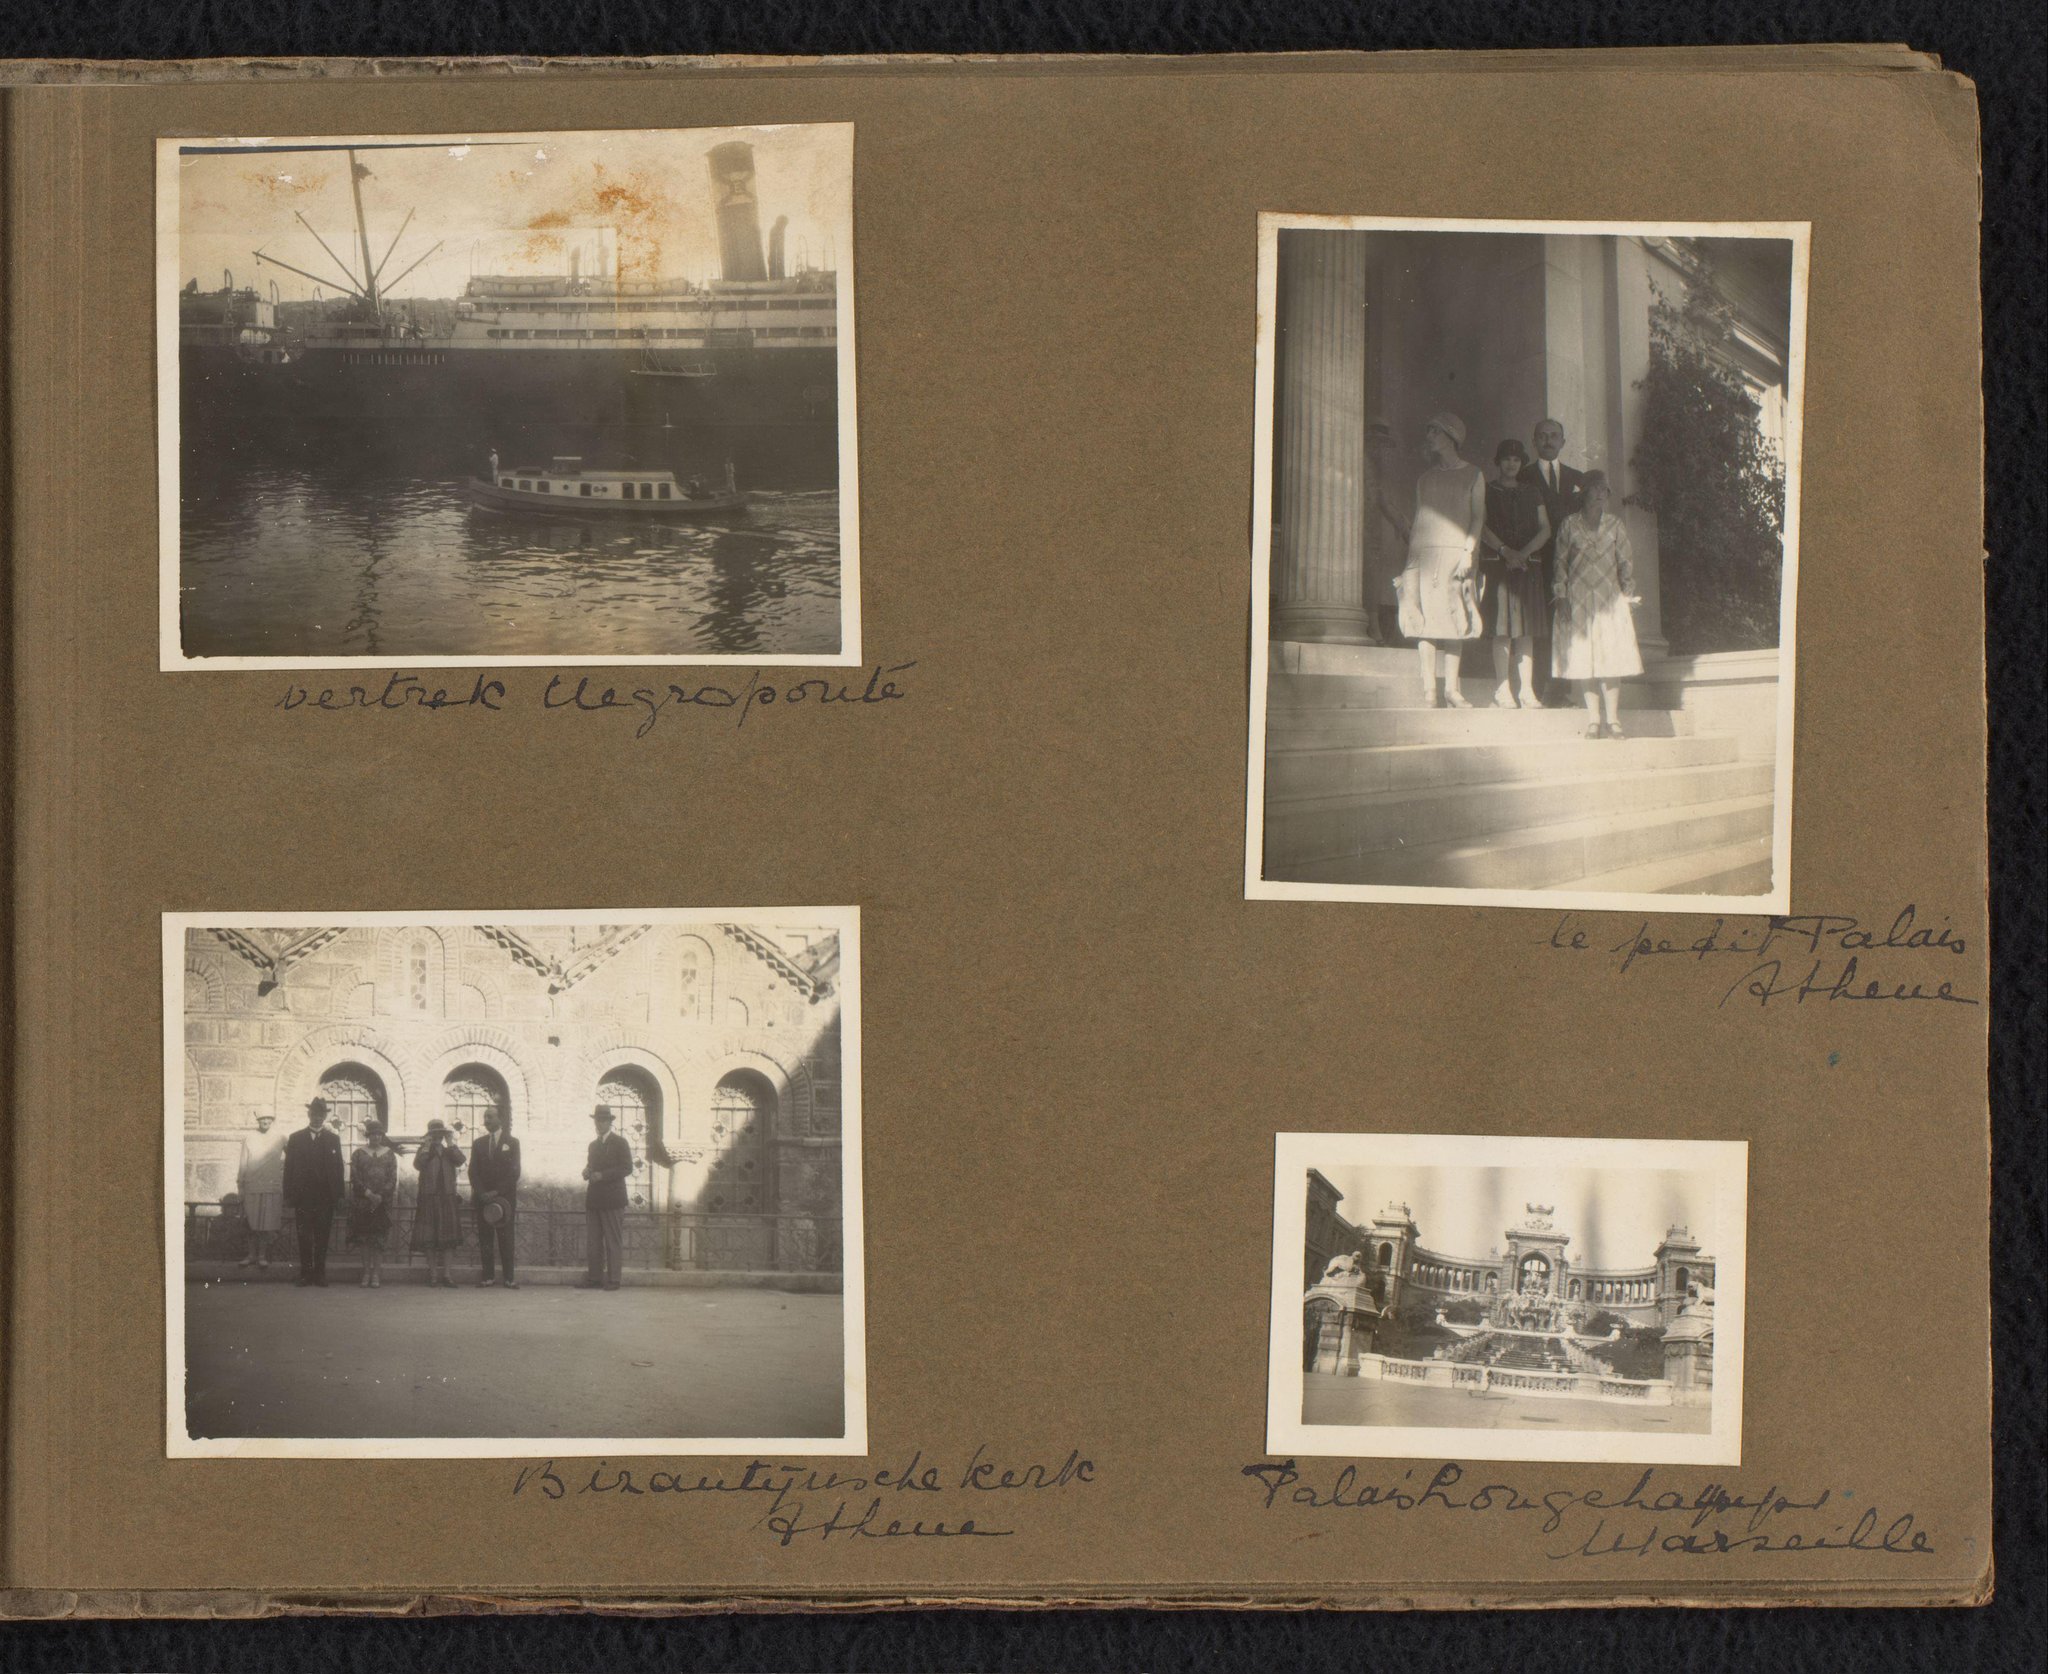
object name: album leaf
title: Vier foto's van een reis naar Marseille en Griekenland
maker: carolina frederika onnen (lien/loen)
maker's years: 1896-1983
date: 1909-1926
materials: paper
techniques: gelatin silver print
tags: church (exterior), steamship, motorship, marseille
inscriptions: inscription: ‘le petit Palais/ Athene’, inscription: ‘vertrek Negroponte’, inscription: ‘Palais Longchamps,/ Marseille’, inscription: ‘Bizantijnse kerk/ Athene’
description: Deze foto's maken deel uit van een album.